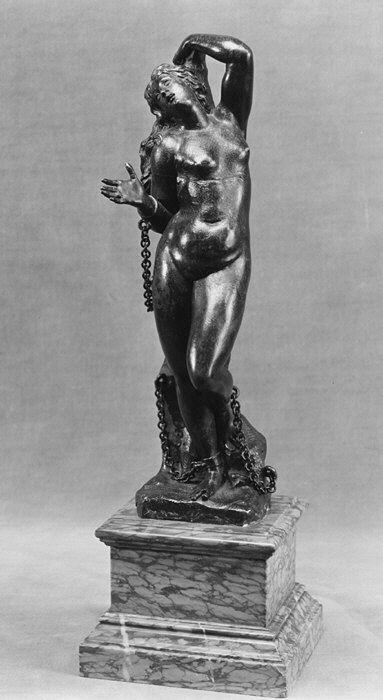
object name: statuette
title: Andromeda Chained to a Rock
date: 1634-1666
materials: bronze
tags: andromeda